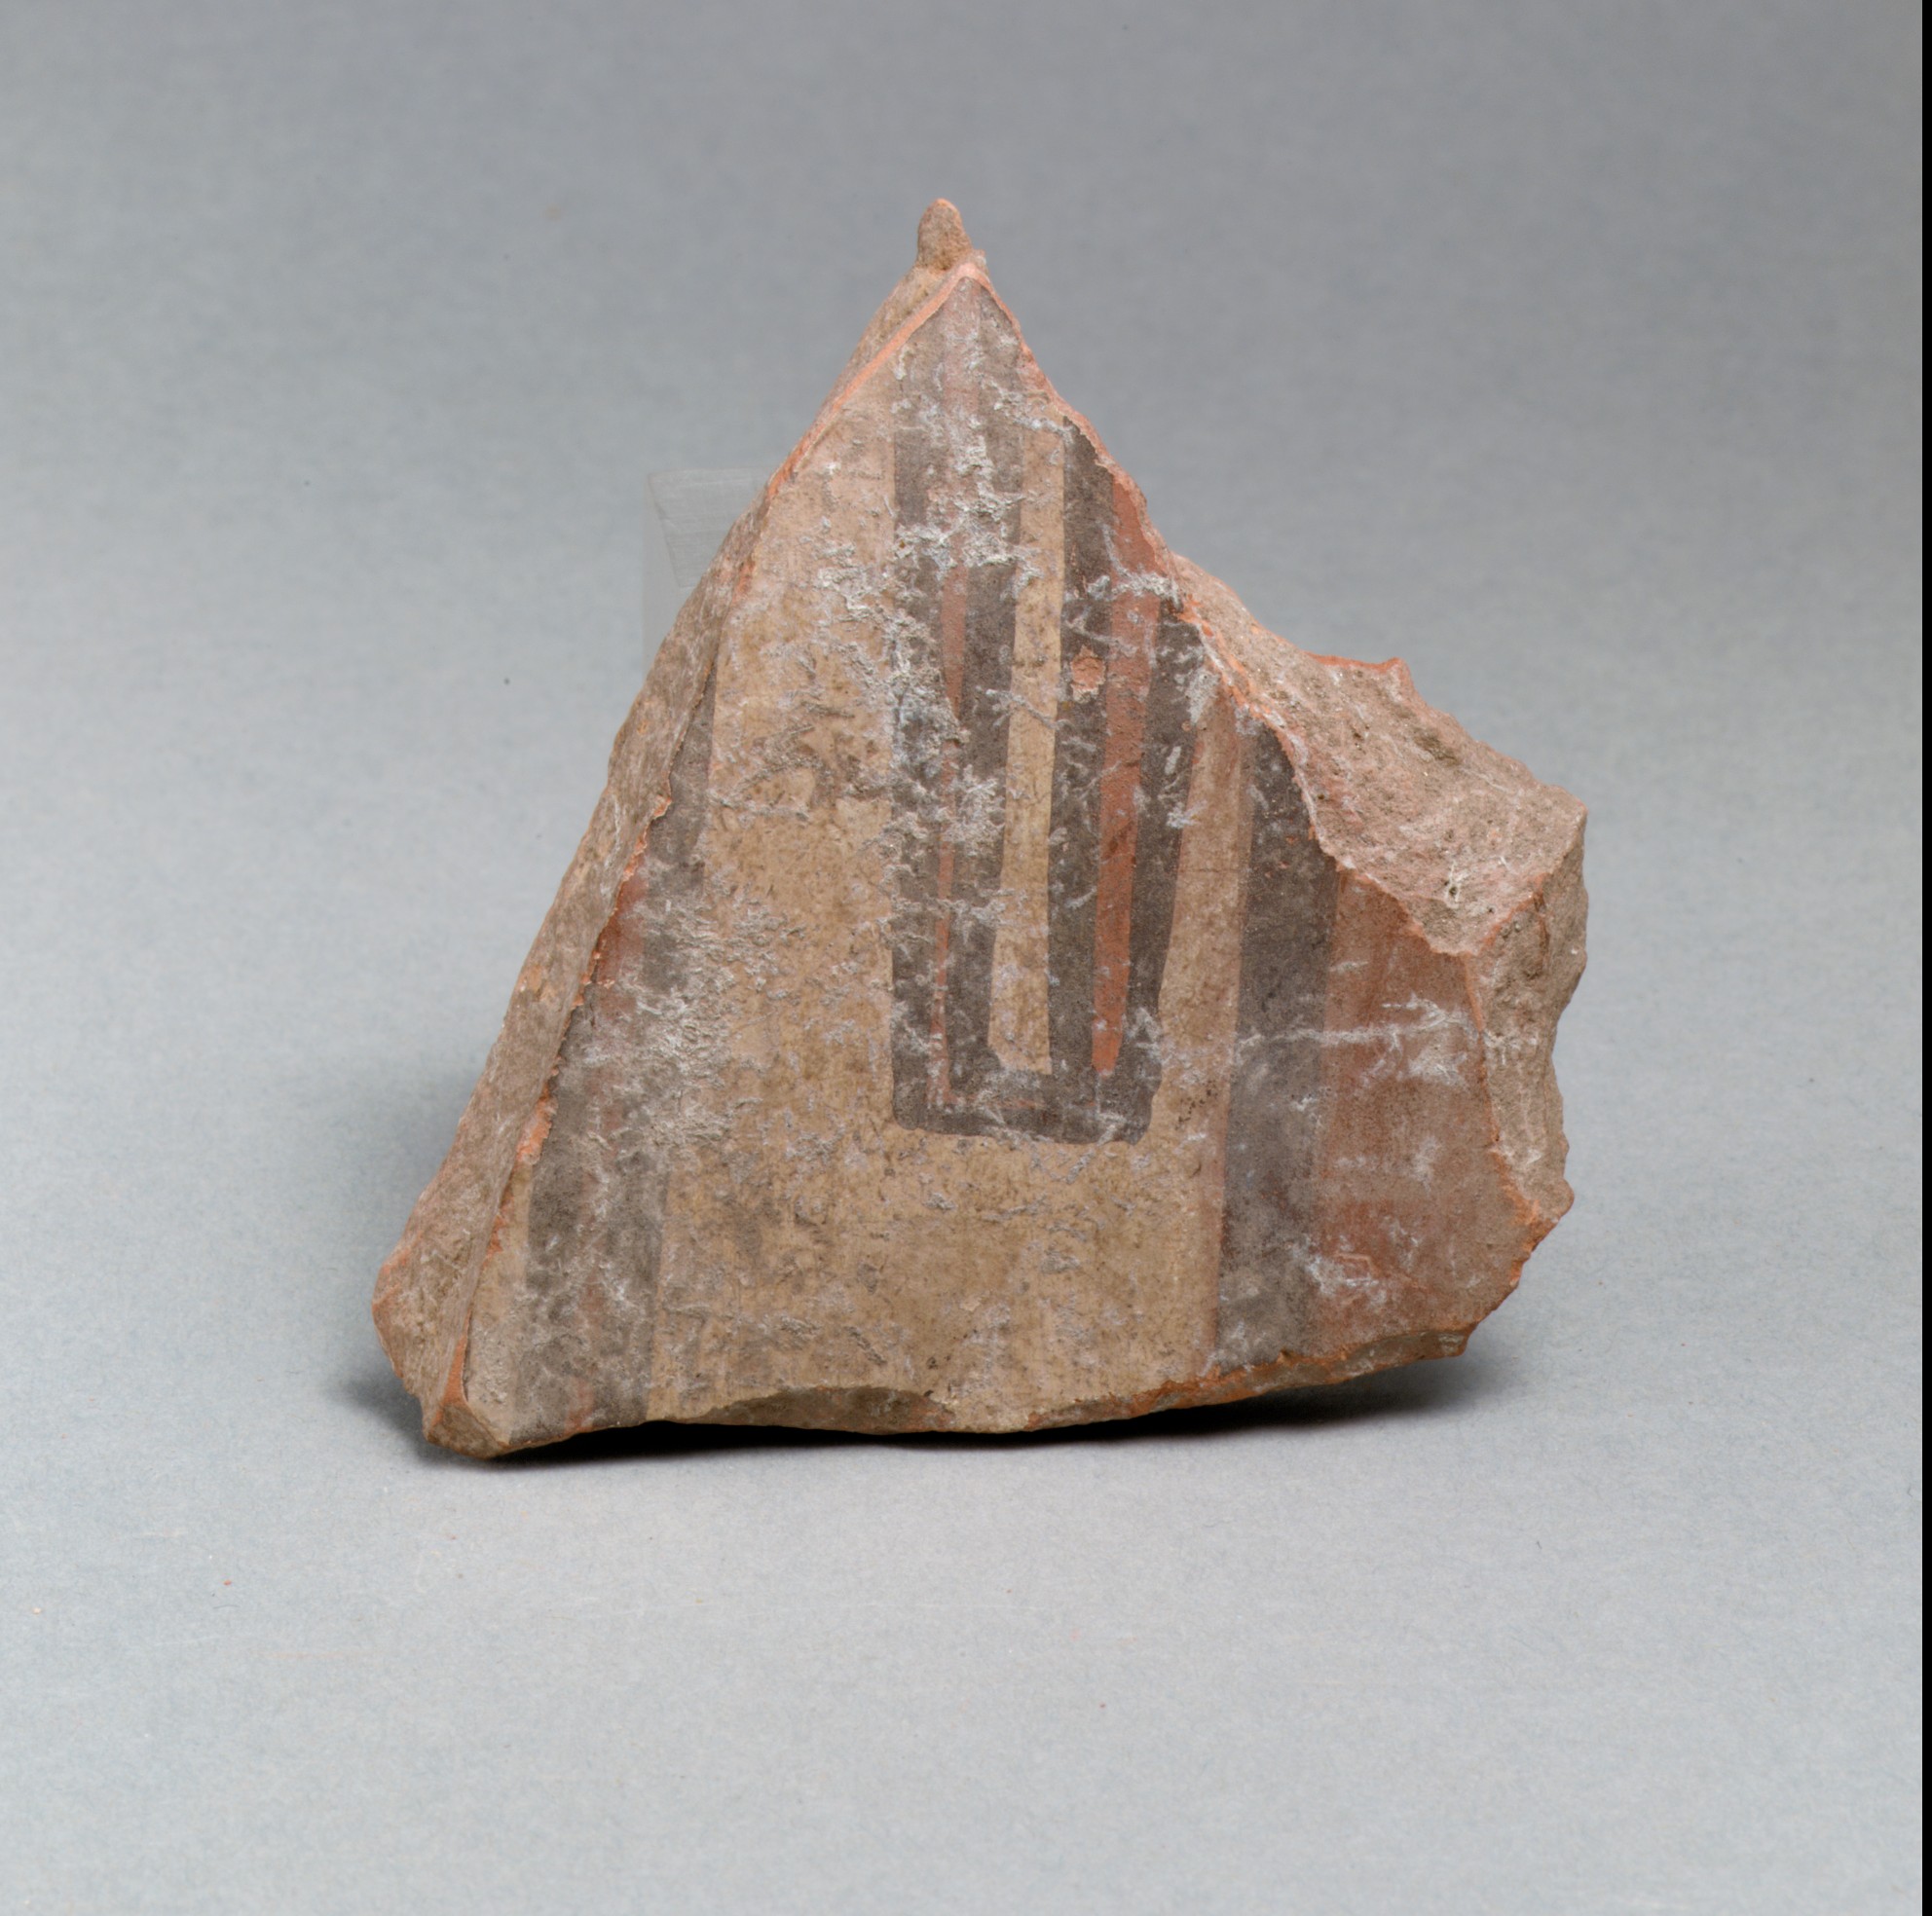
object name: vase fragment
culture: greek or lydian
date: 800-480 BCE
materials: terracotta